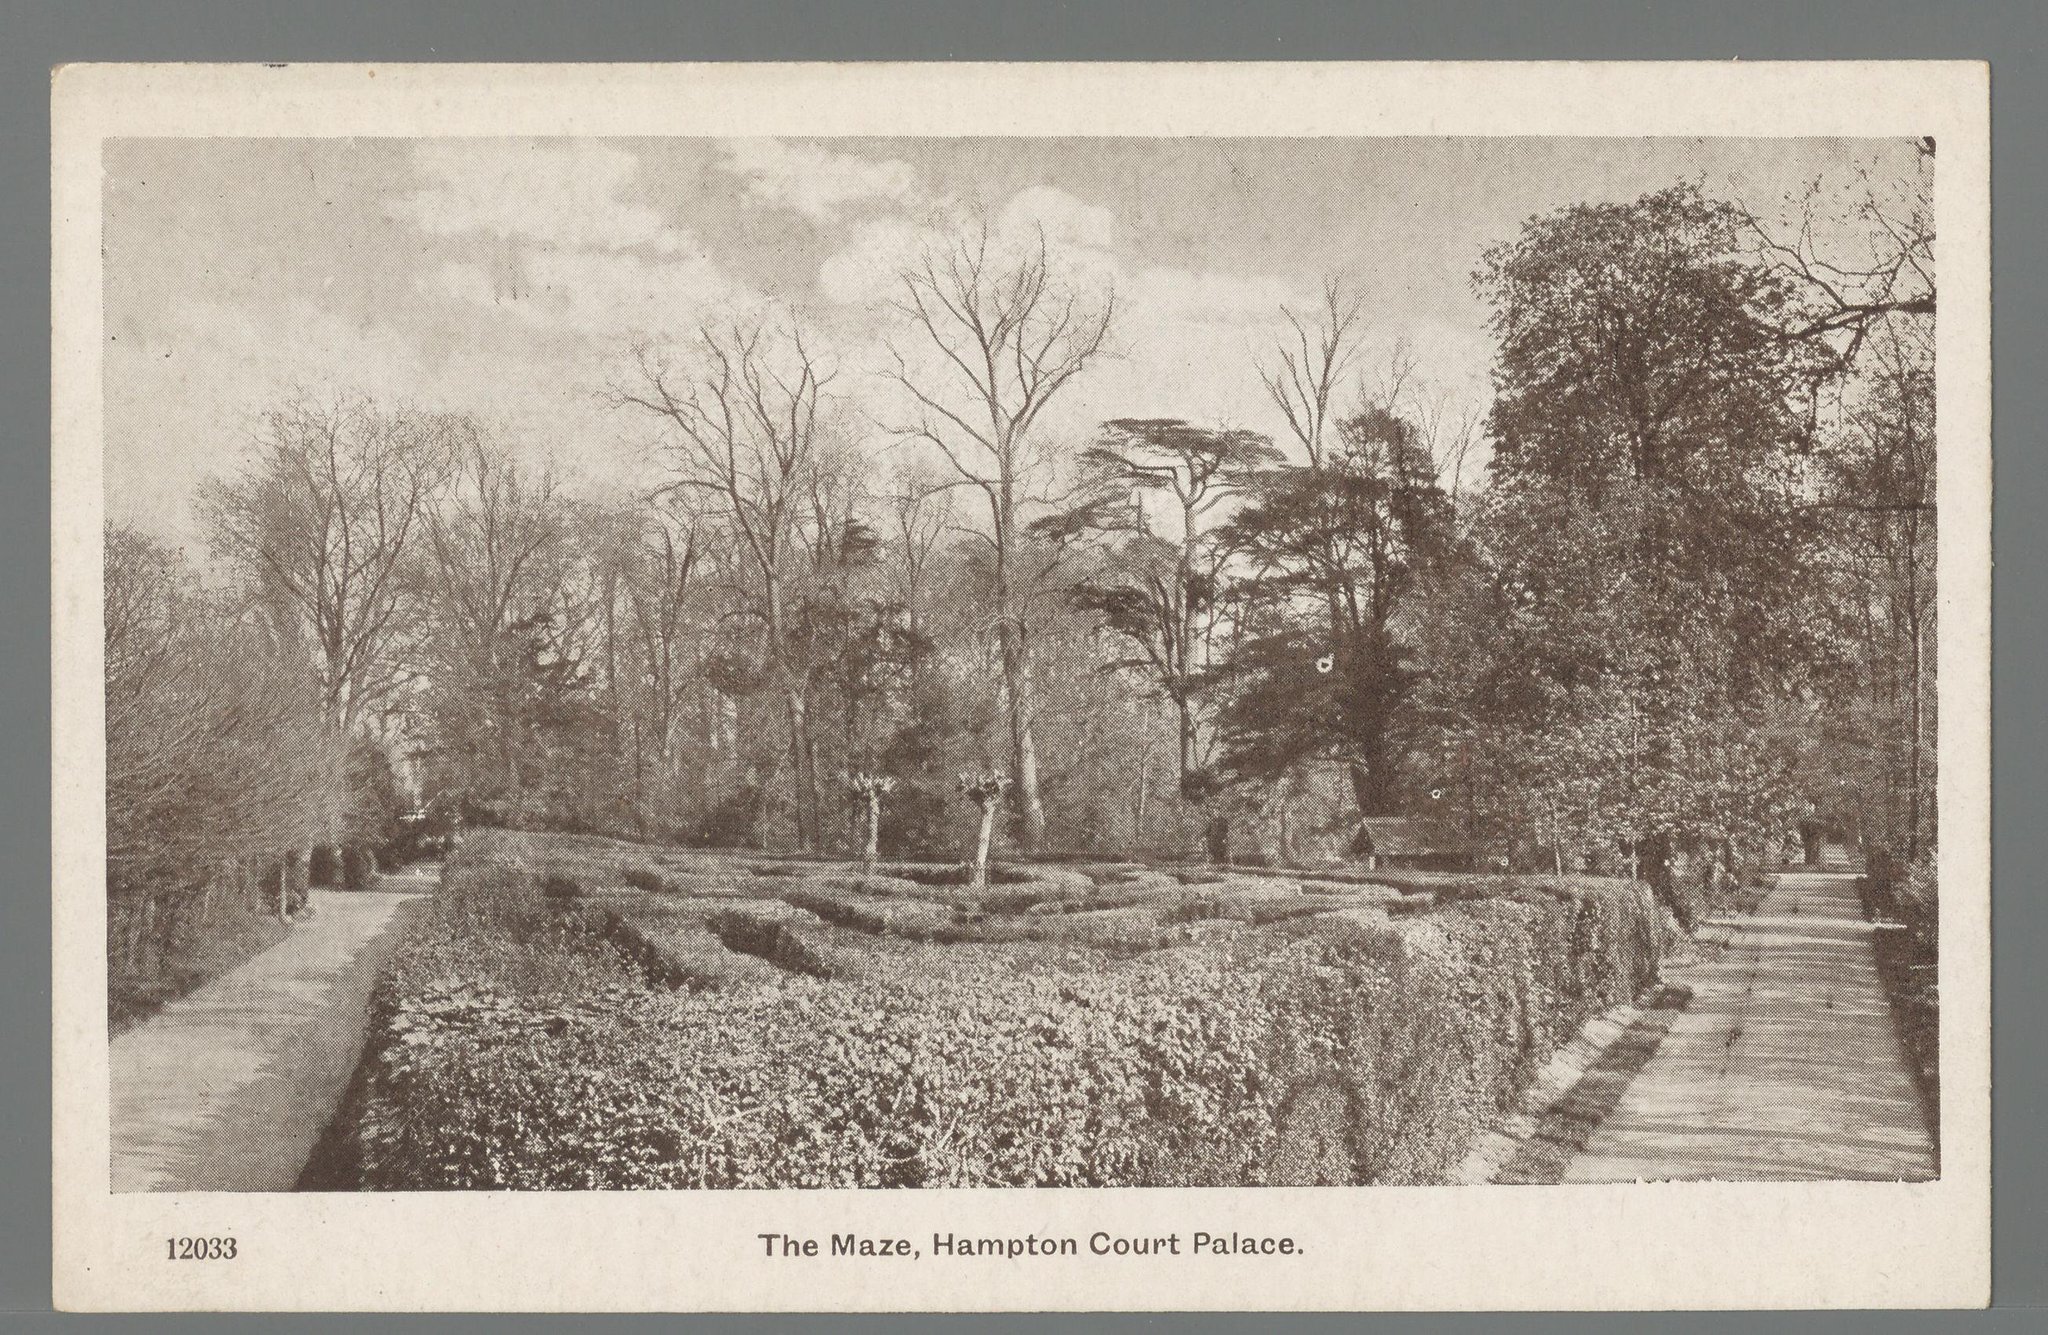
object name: ansichtkaart, prentbriefkaart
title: The G&P Series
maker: Anonymous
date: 1915-1930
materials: cardboard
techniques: autotype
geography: london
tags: palace, labyrinth, maze ~ garden